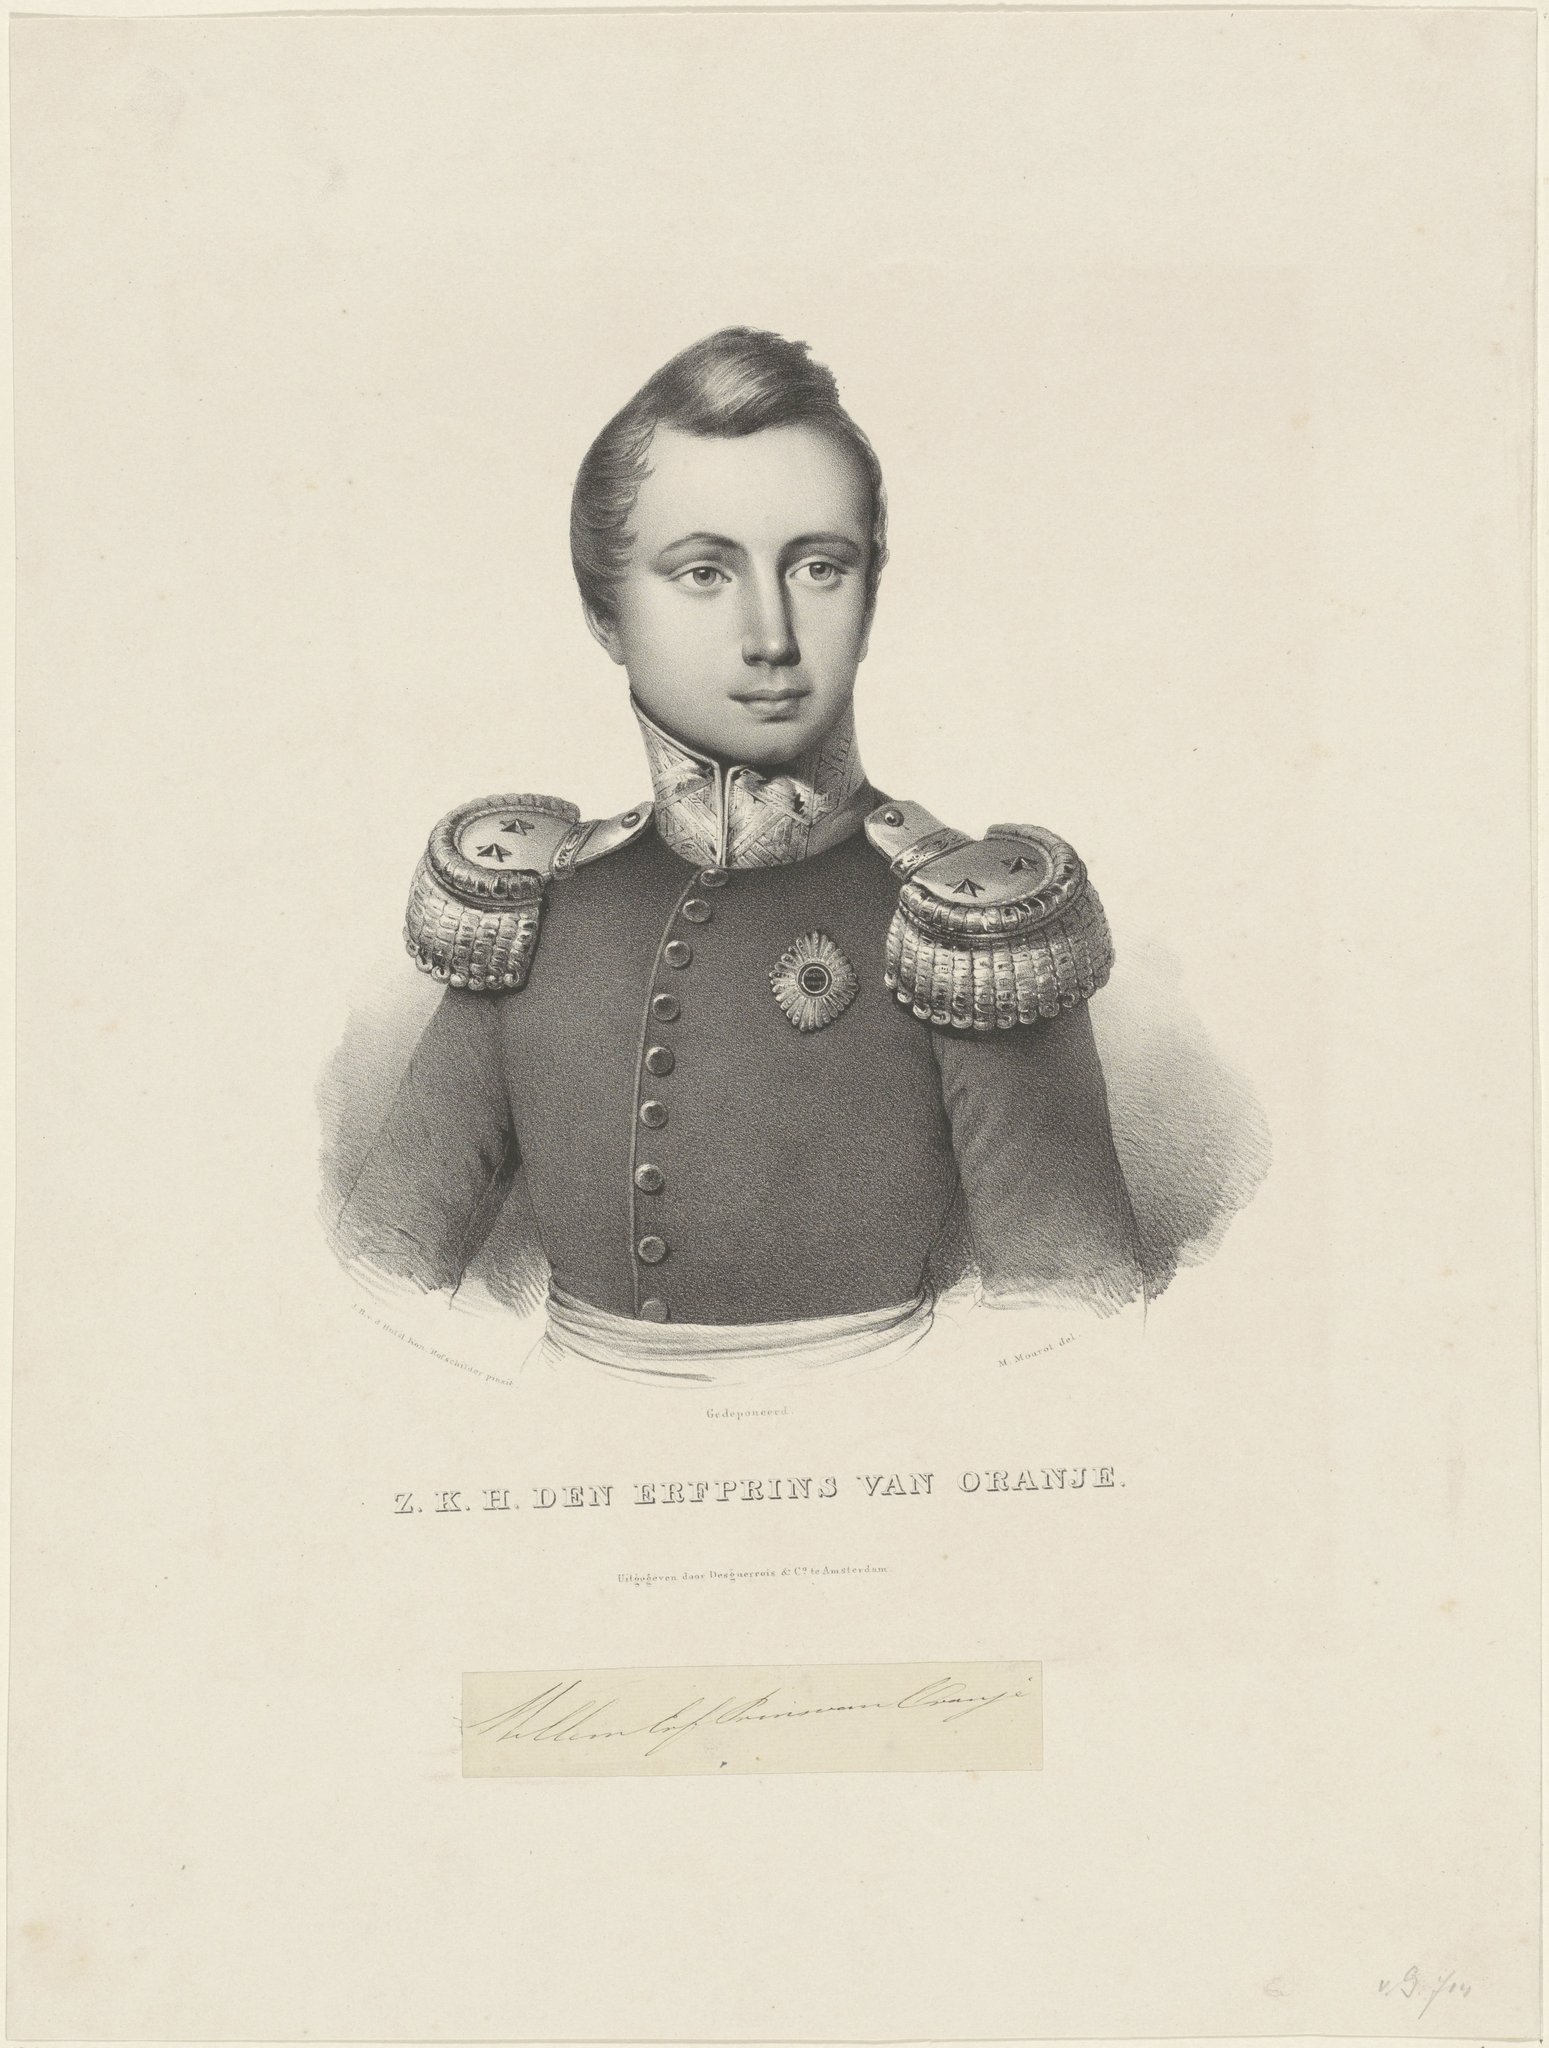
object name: print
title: Portret van Willem III, koning der Nederlanden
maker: jean-baptiste van der hulst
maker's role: draughtsman, painter, print maker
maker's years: 1790-1862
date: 1839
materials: paper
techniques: lithograph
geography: amsterdam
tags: willem iii (koning der nederlanden)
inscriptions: octrooivermelding, gedrukt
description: De hier vermelde titel verwijst naar de hoogst verkregen titel van de geportretteerde, niet per se naar de titel die de geportretteerde op deze voorstelling draagt.